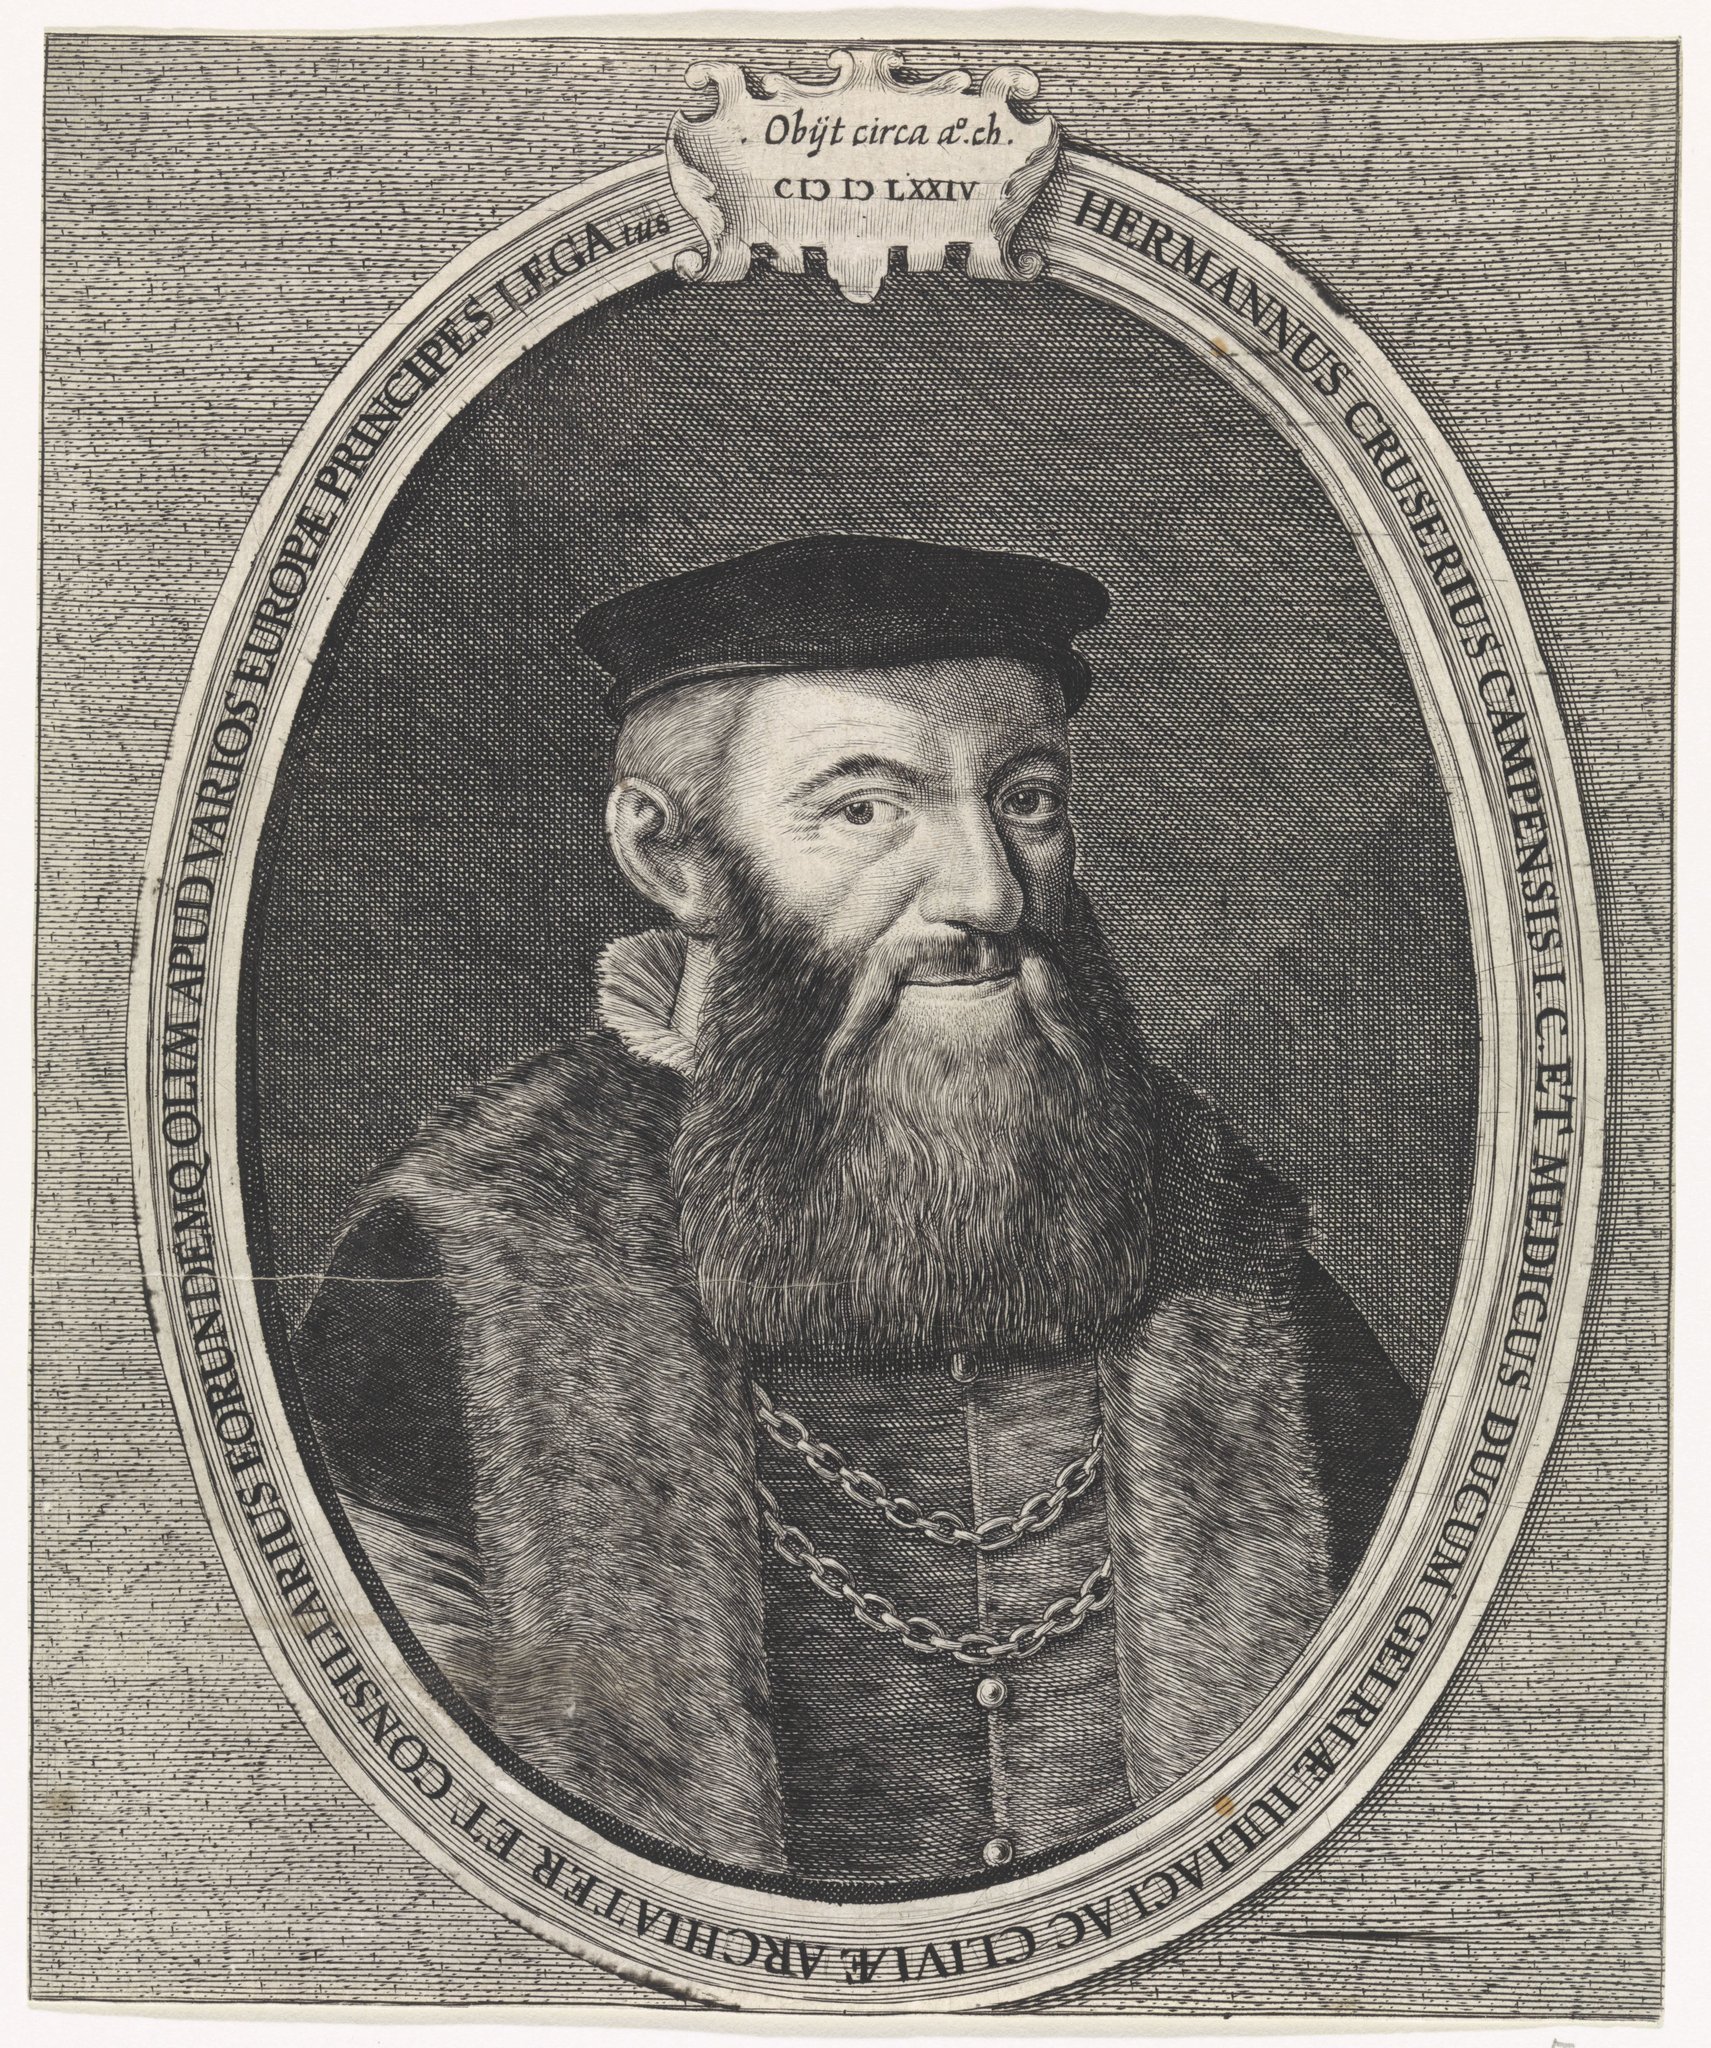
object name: print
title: Portret van Herman Cruser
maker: crispijn van de passe (ii)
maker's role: draughtsman, print maker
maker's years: 1594-1670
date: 1604-1670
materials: paper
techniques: engraving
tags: humanist, herman cruser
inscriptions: collector's mark: Lugt 2228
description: Portret van Herman Cruser, lijfarts van de hertog van Gelre. In het randschrift van de omlijsting de naam, functie en sterfdatum van de geportretteerde in het Latijn.